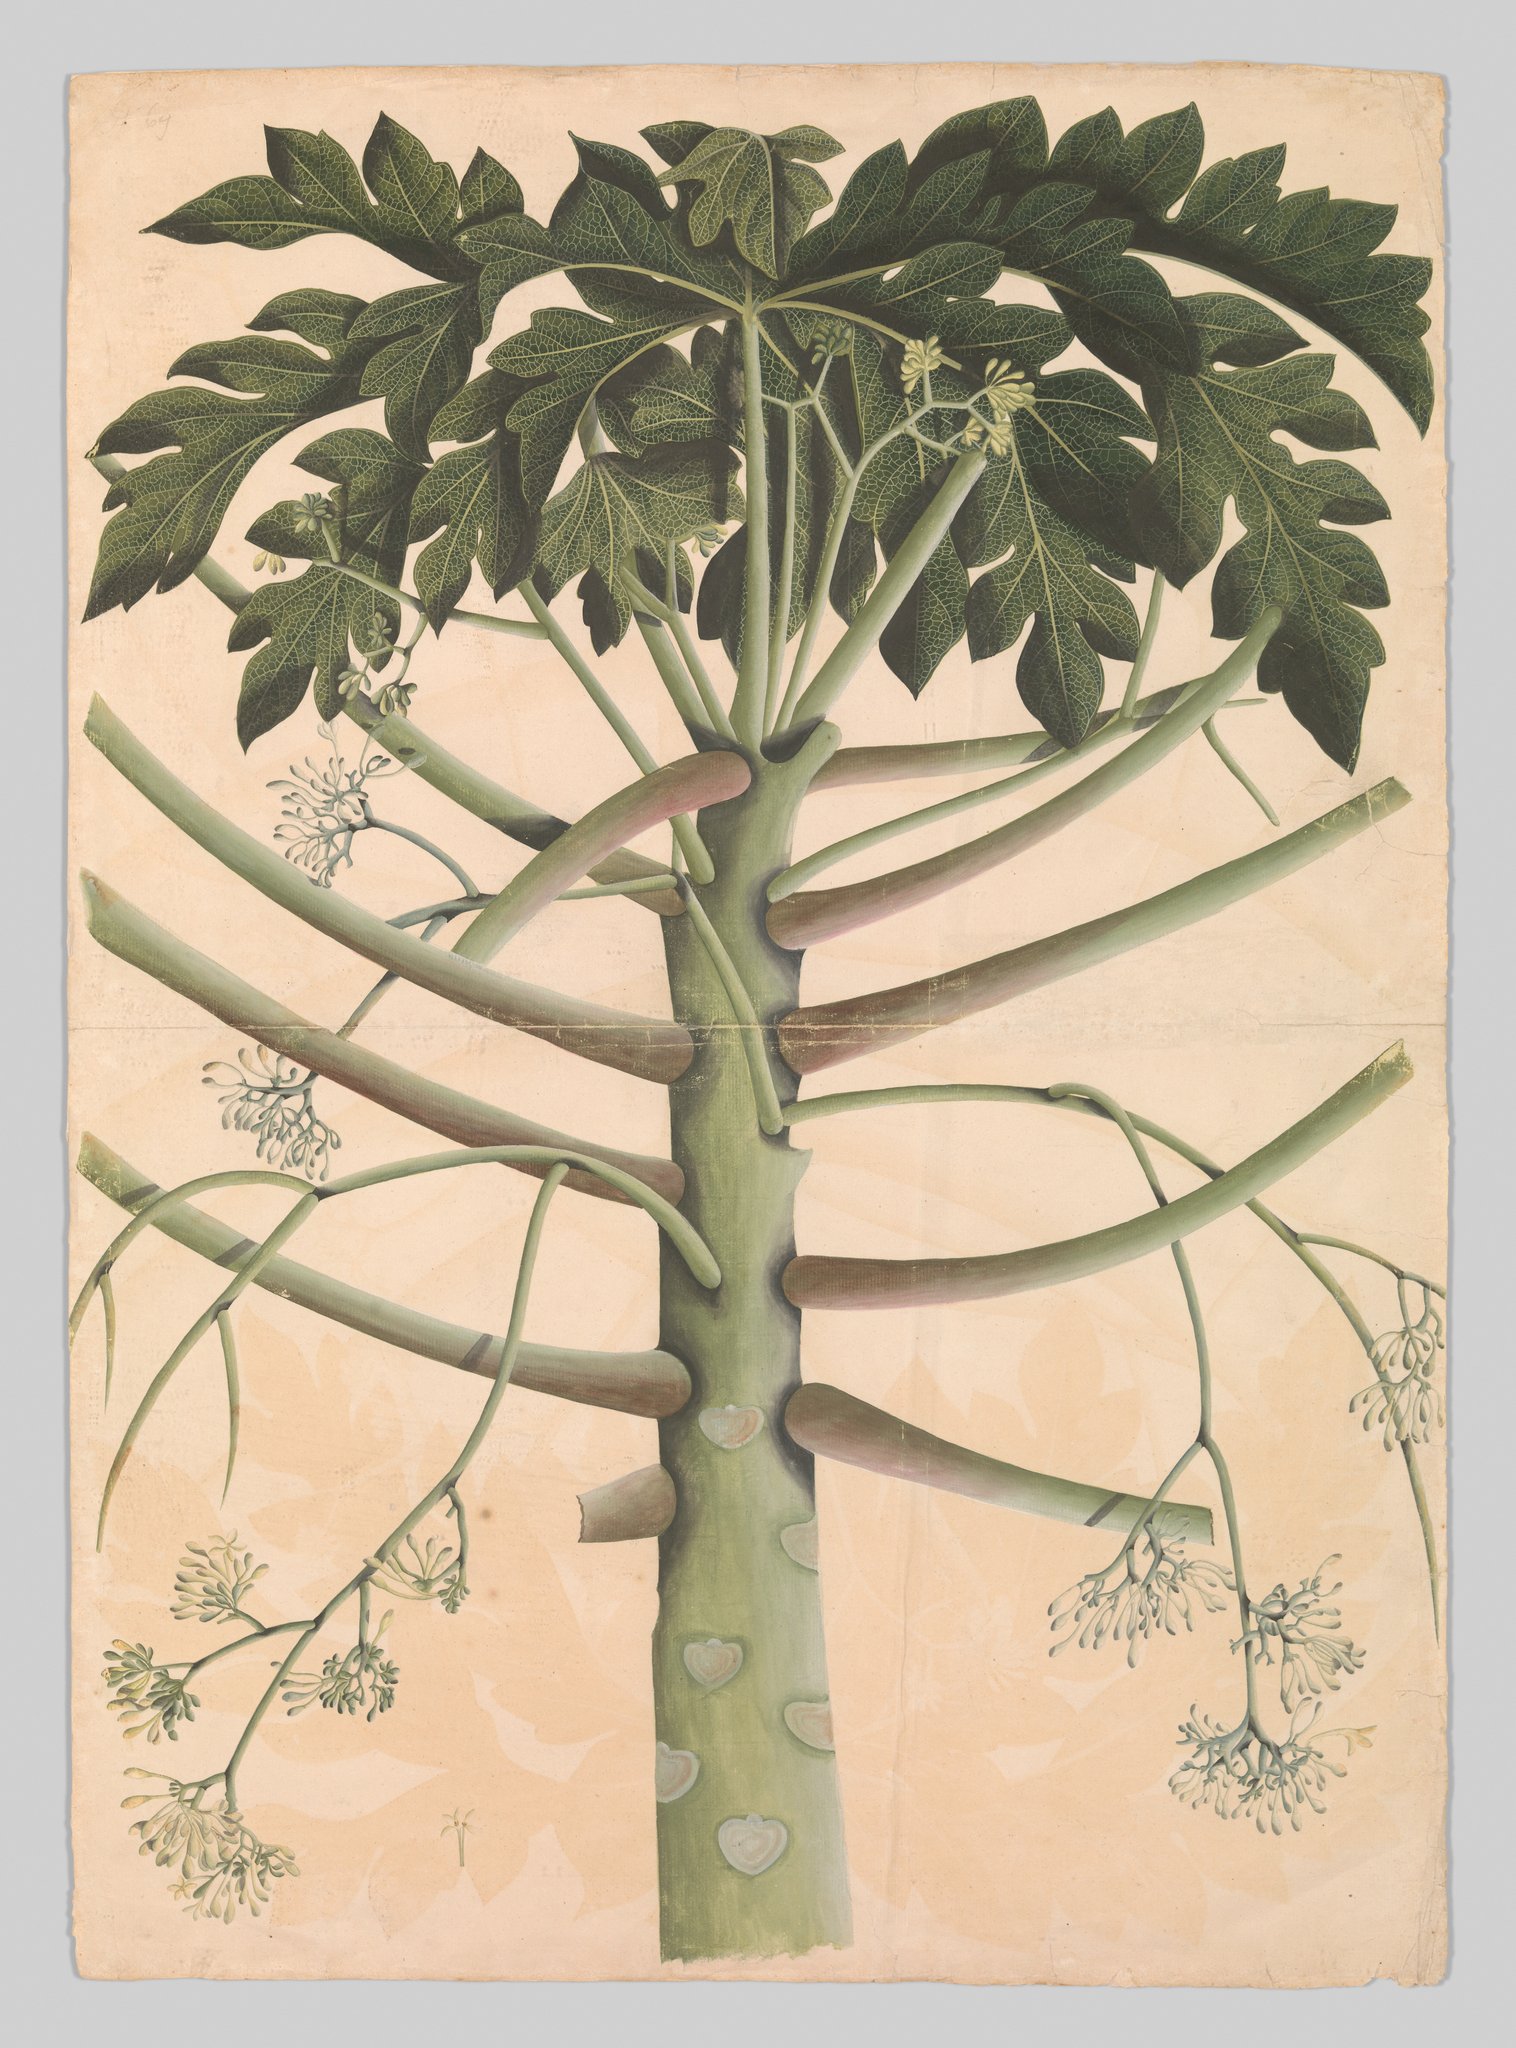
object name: illustrated single work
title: Male Papaya Tree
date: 1790-1800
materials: paper, watercolor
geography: india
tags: trees